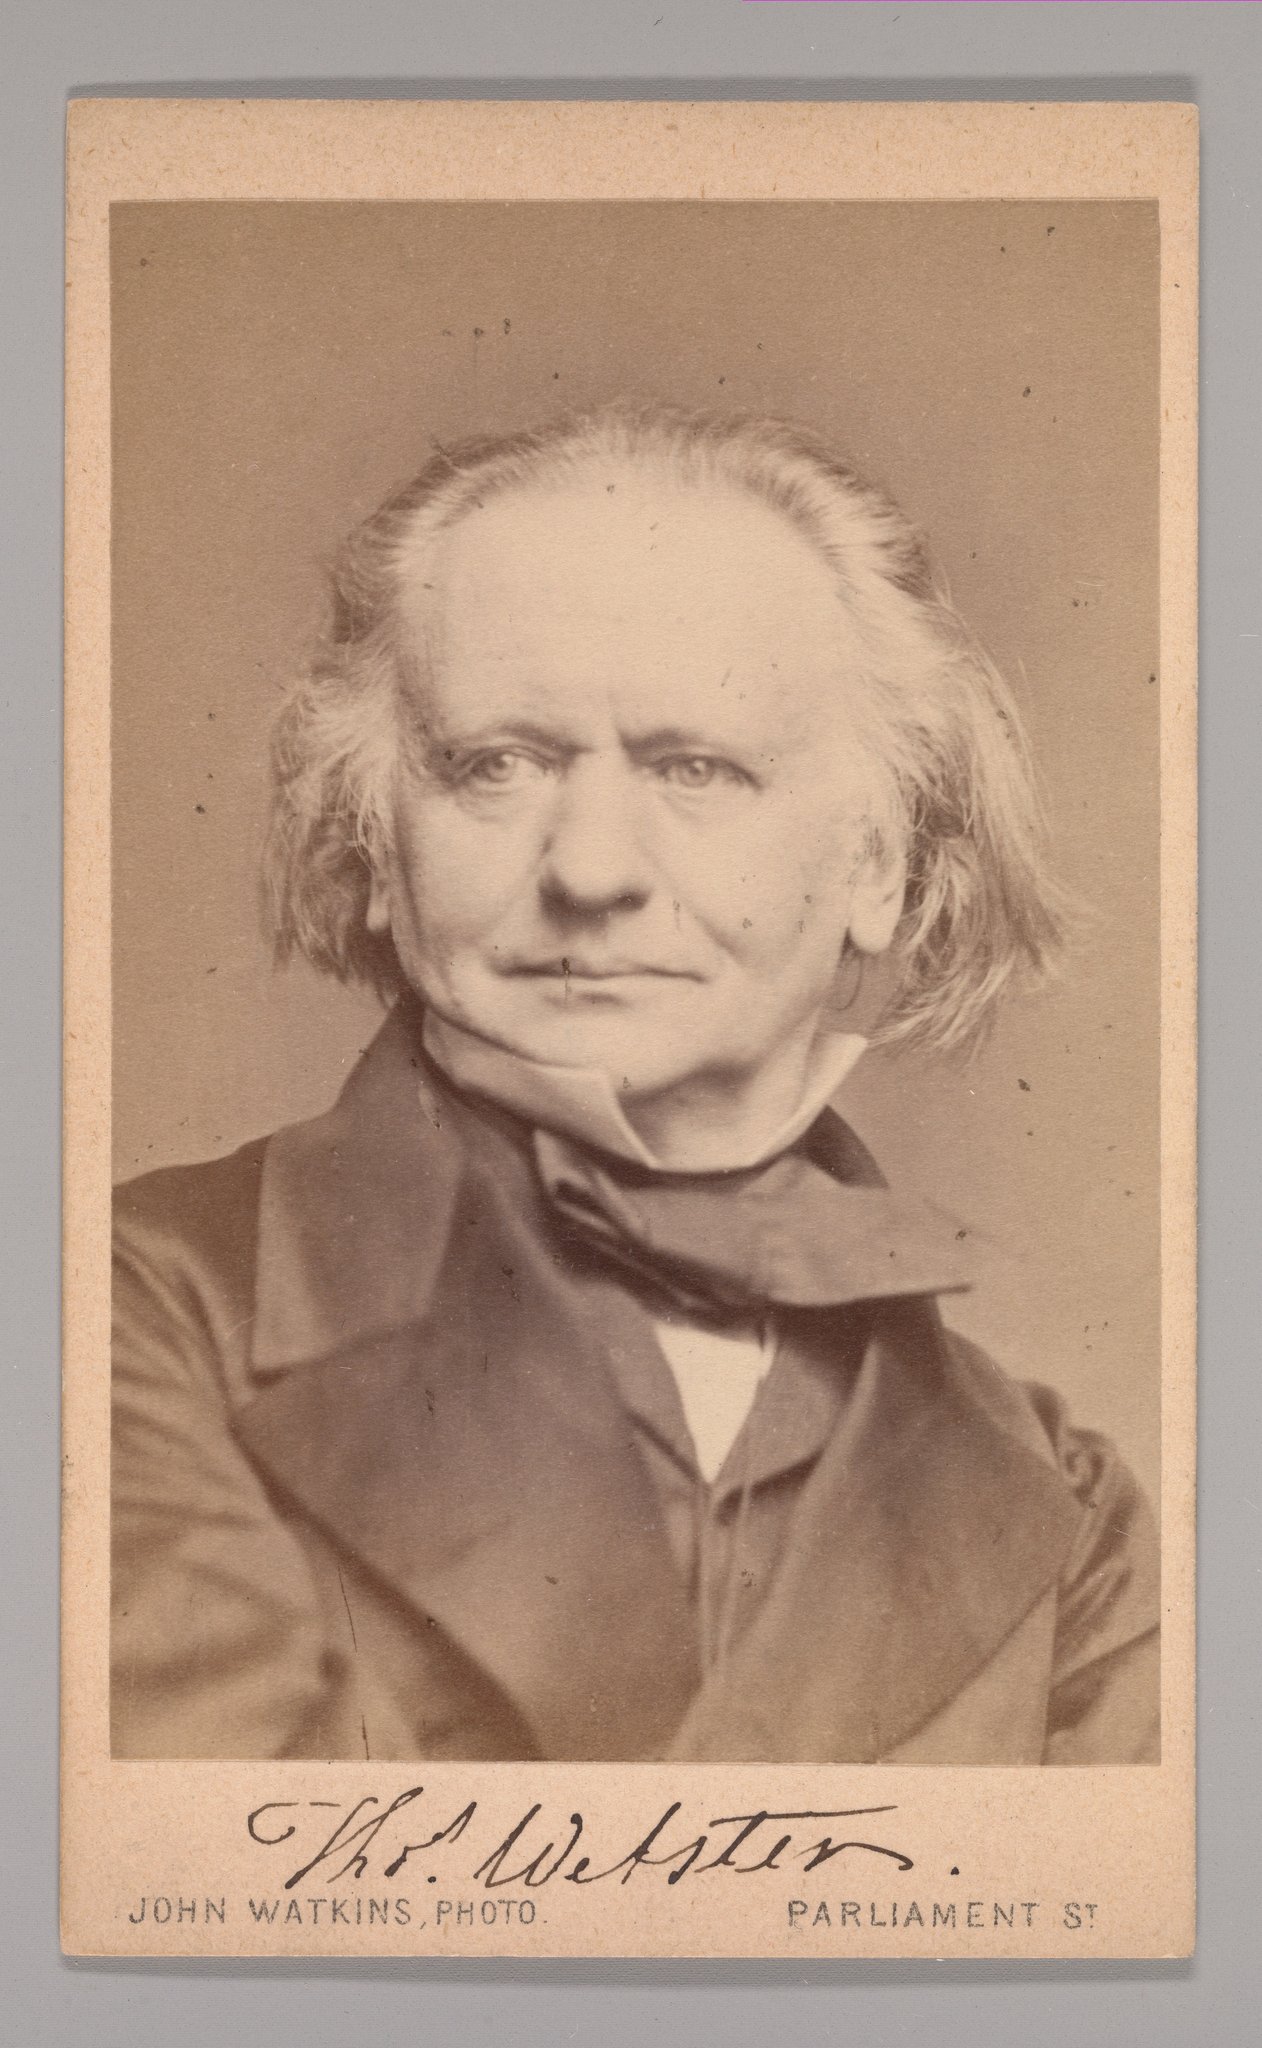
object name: carte de visite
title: [Thomas Webster]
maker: john and charles watkins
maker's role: photography studio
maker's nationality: british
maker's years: 1840-1875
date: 1860-1869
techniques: albumen silver print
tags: men,portraits